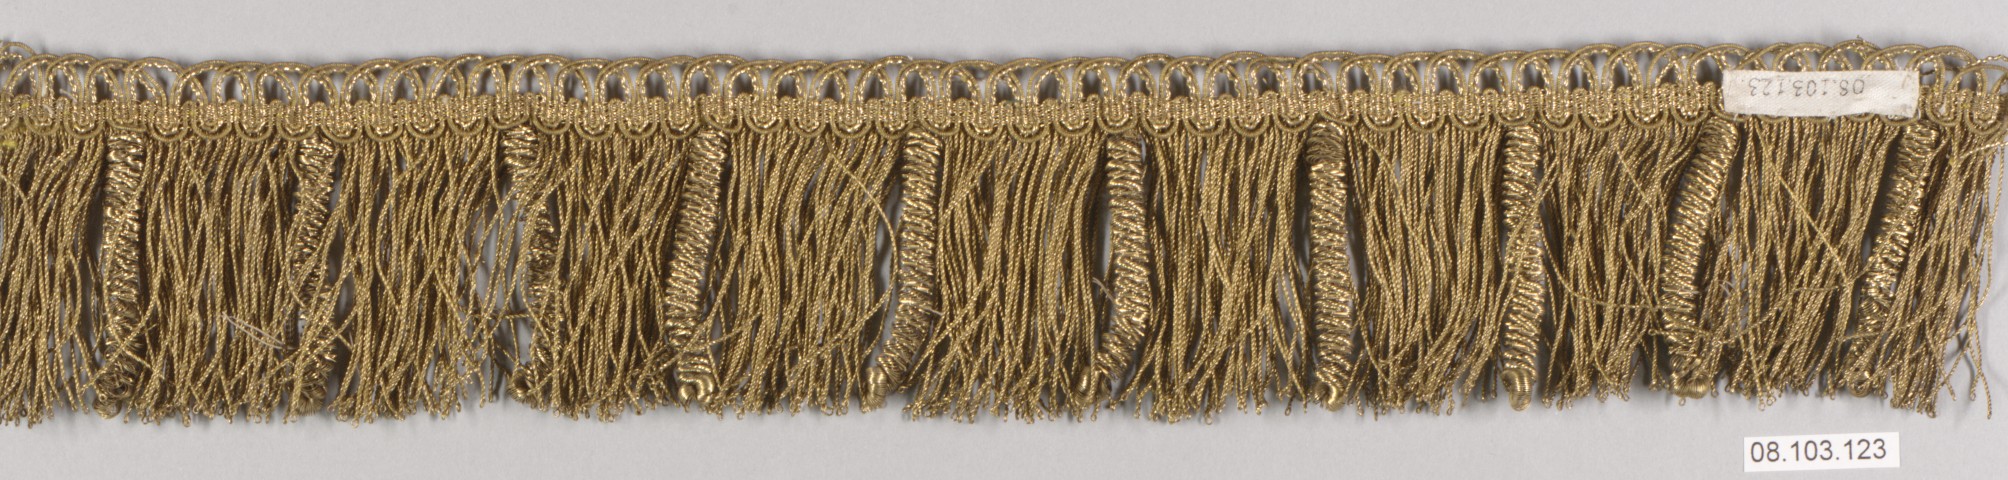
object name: fringe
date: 1801-1900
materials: metal thread